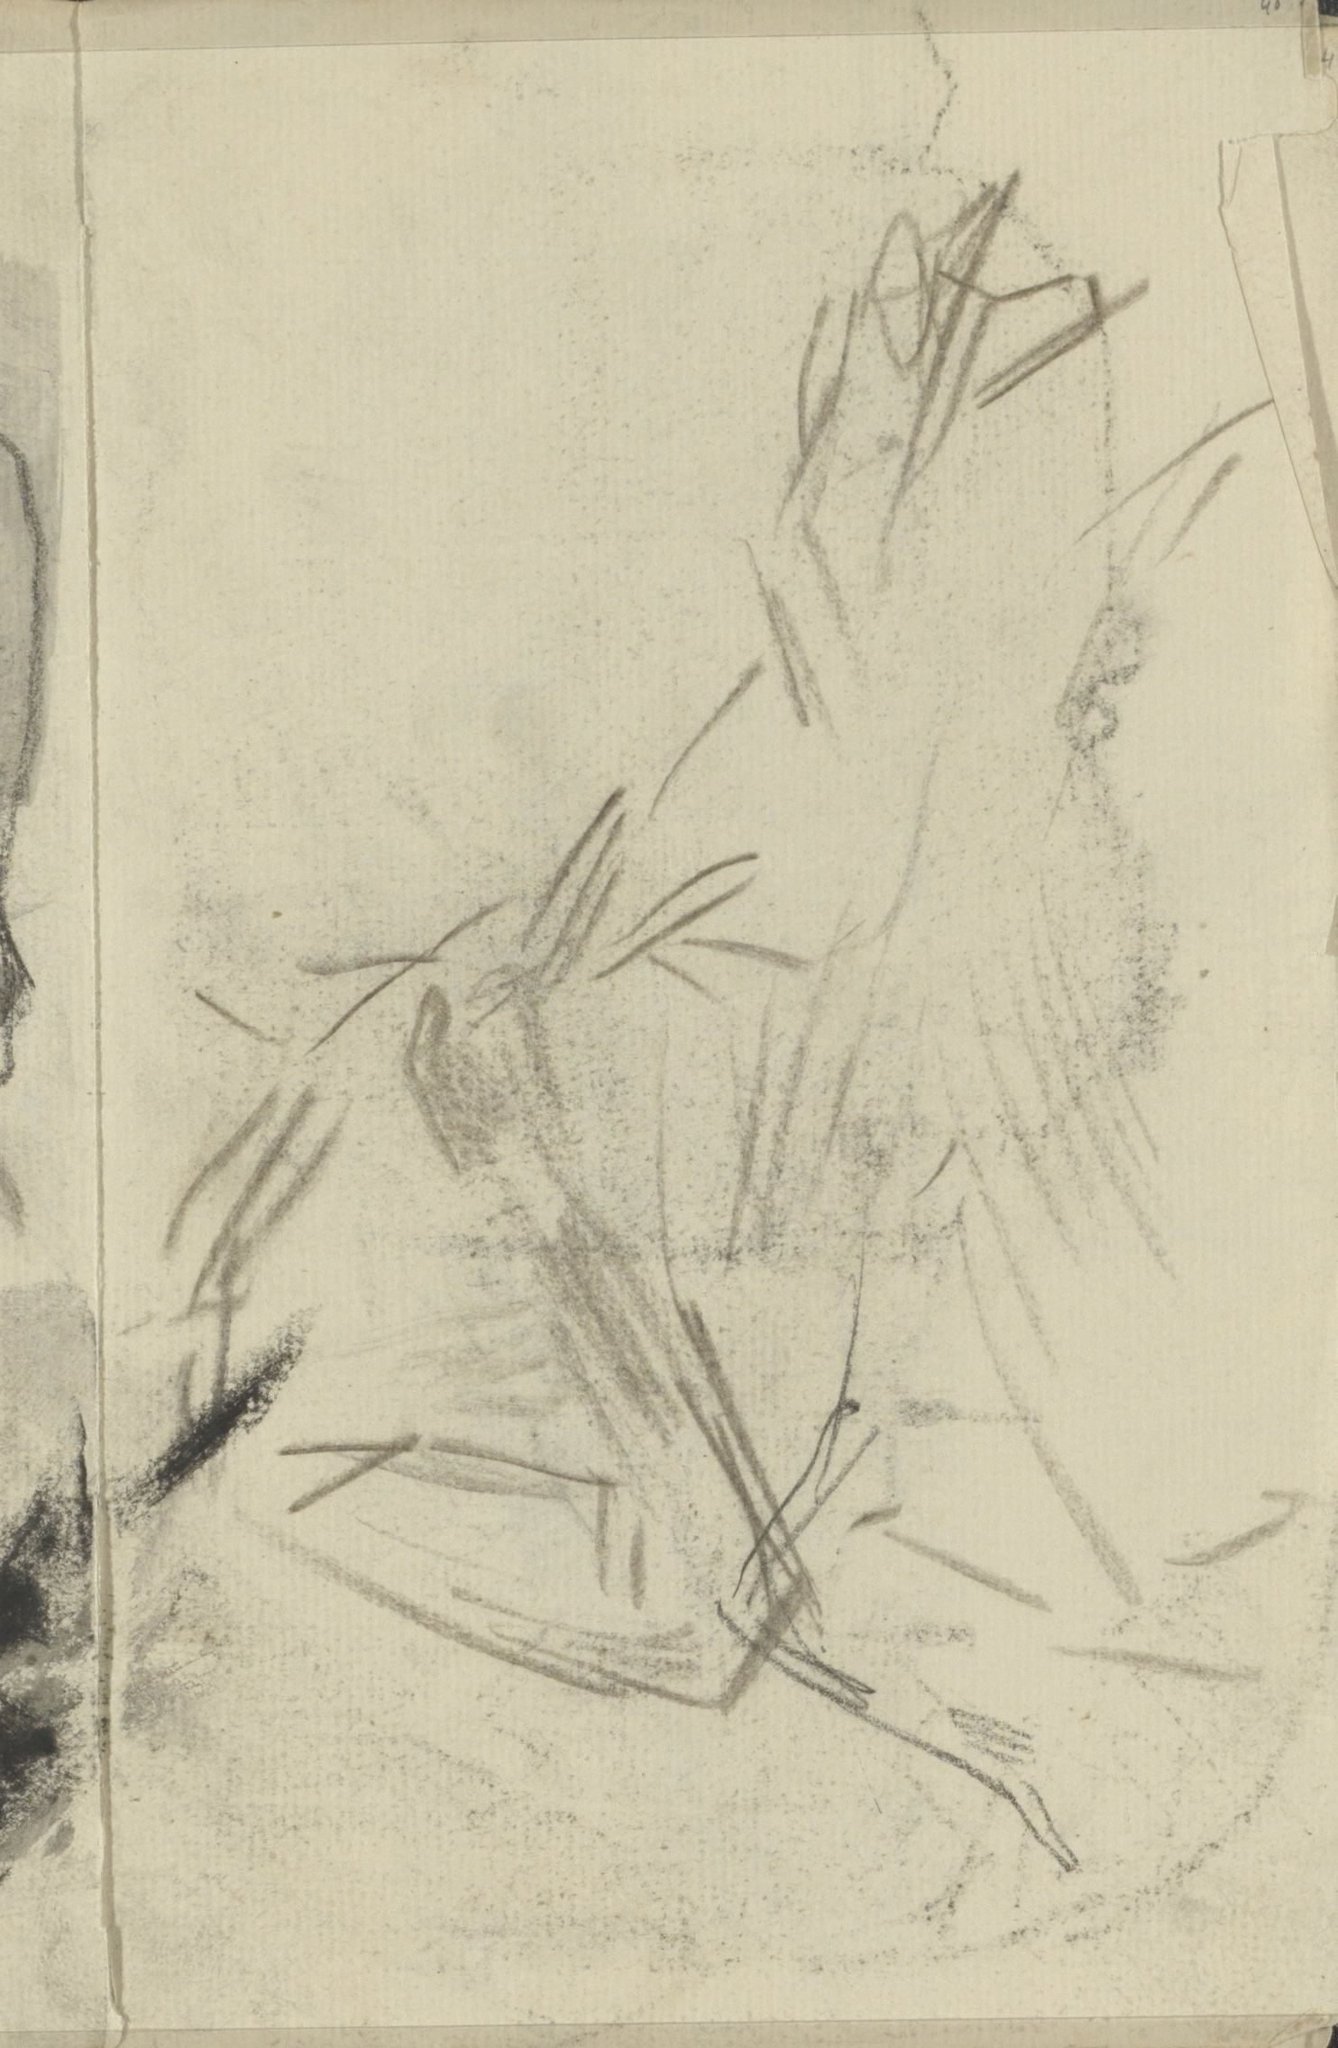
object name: sketchbook leaf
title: Studie, mogelijk van een zittende figuur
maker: george hendrik breitner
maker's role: draughtsman, painter, print maker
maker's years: 1857-1923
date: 1882-1884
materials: chalk, paper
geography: the hague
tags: sitting figure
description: Pagina 40 uit een schetsboek met 24 bladen.